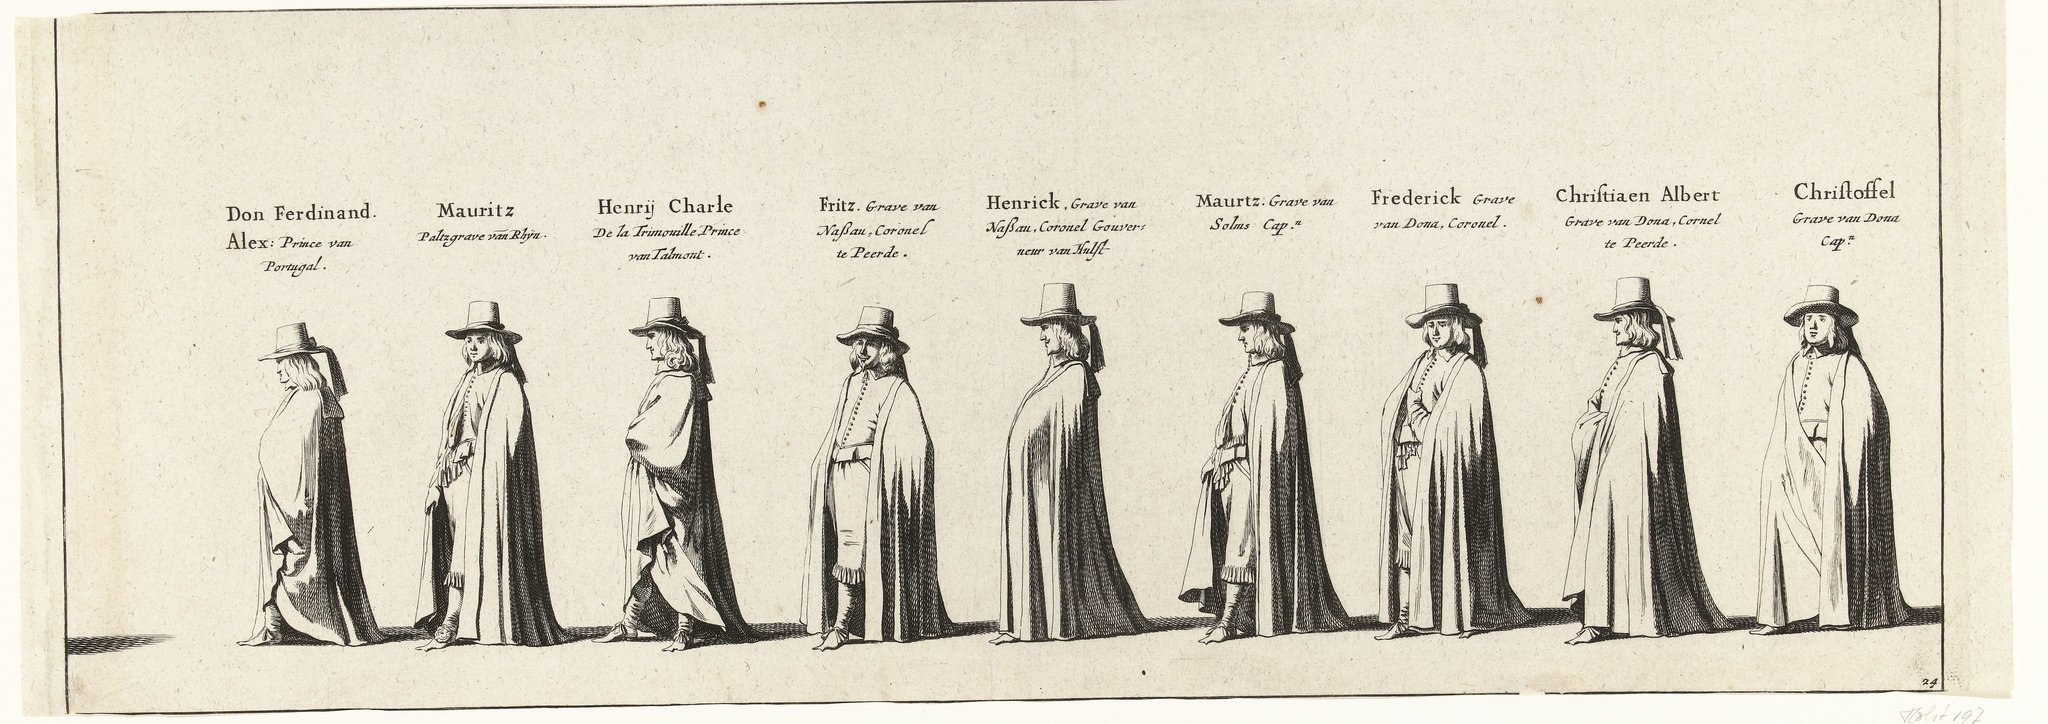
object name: print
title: De begrafenisstoet van Frederik Hendrik (plaat nr. 24), 1647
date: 1647-1651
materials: paper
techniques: etching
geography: northern netherlands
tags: delft, the hague, frederick henry (prince of orange), cortege, funeral procession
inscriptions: collector's mark: Lugt 2228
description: De begrafenisstoet van stadhouder Frederik Hendrik te 's-Gravenhage op 10 mei 1647. Plaat nr. 24 met een deel van de stoet, boven de personen staan hun naam en functie. Onderdeel van een serie van 30 platen en 20 tekstbladen, bedoeld om aan elkaar geplakt te worden.